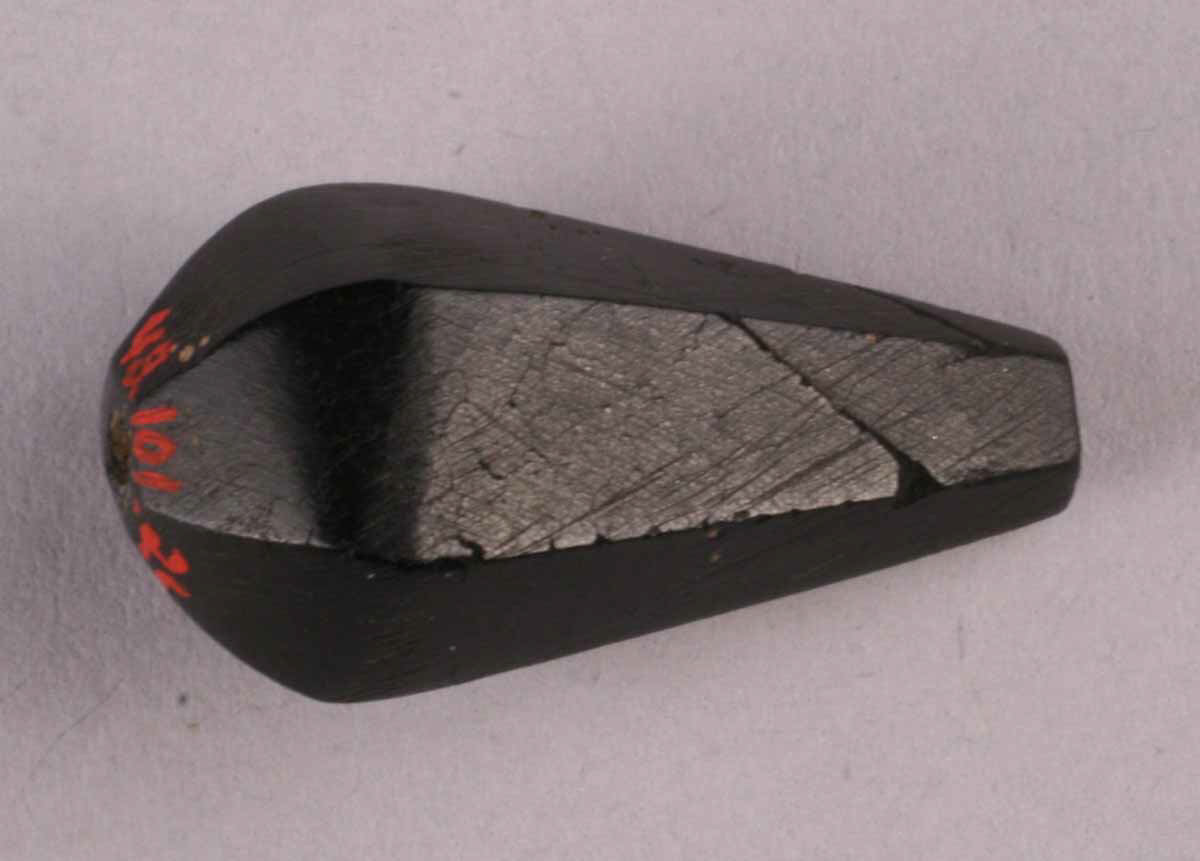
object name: bead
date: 701-1300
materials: stone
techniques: cutting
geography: iran